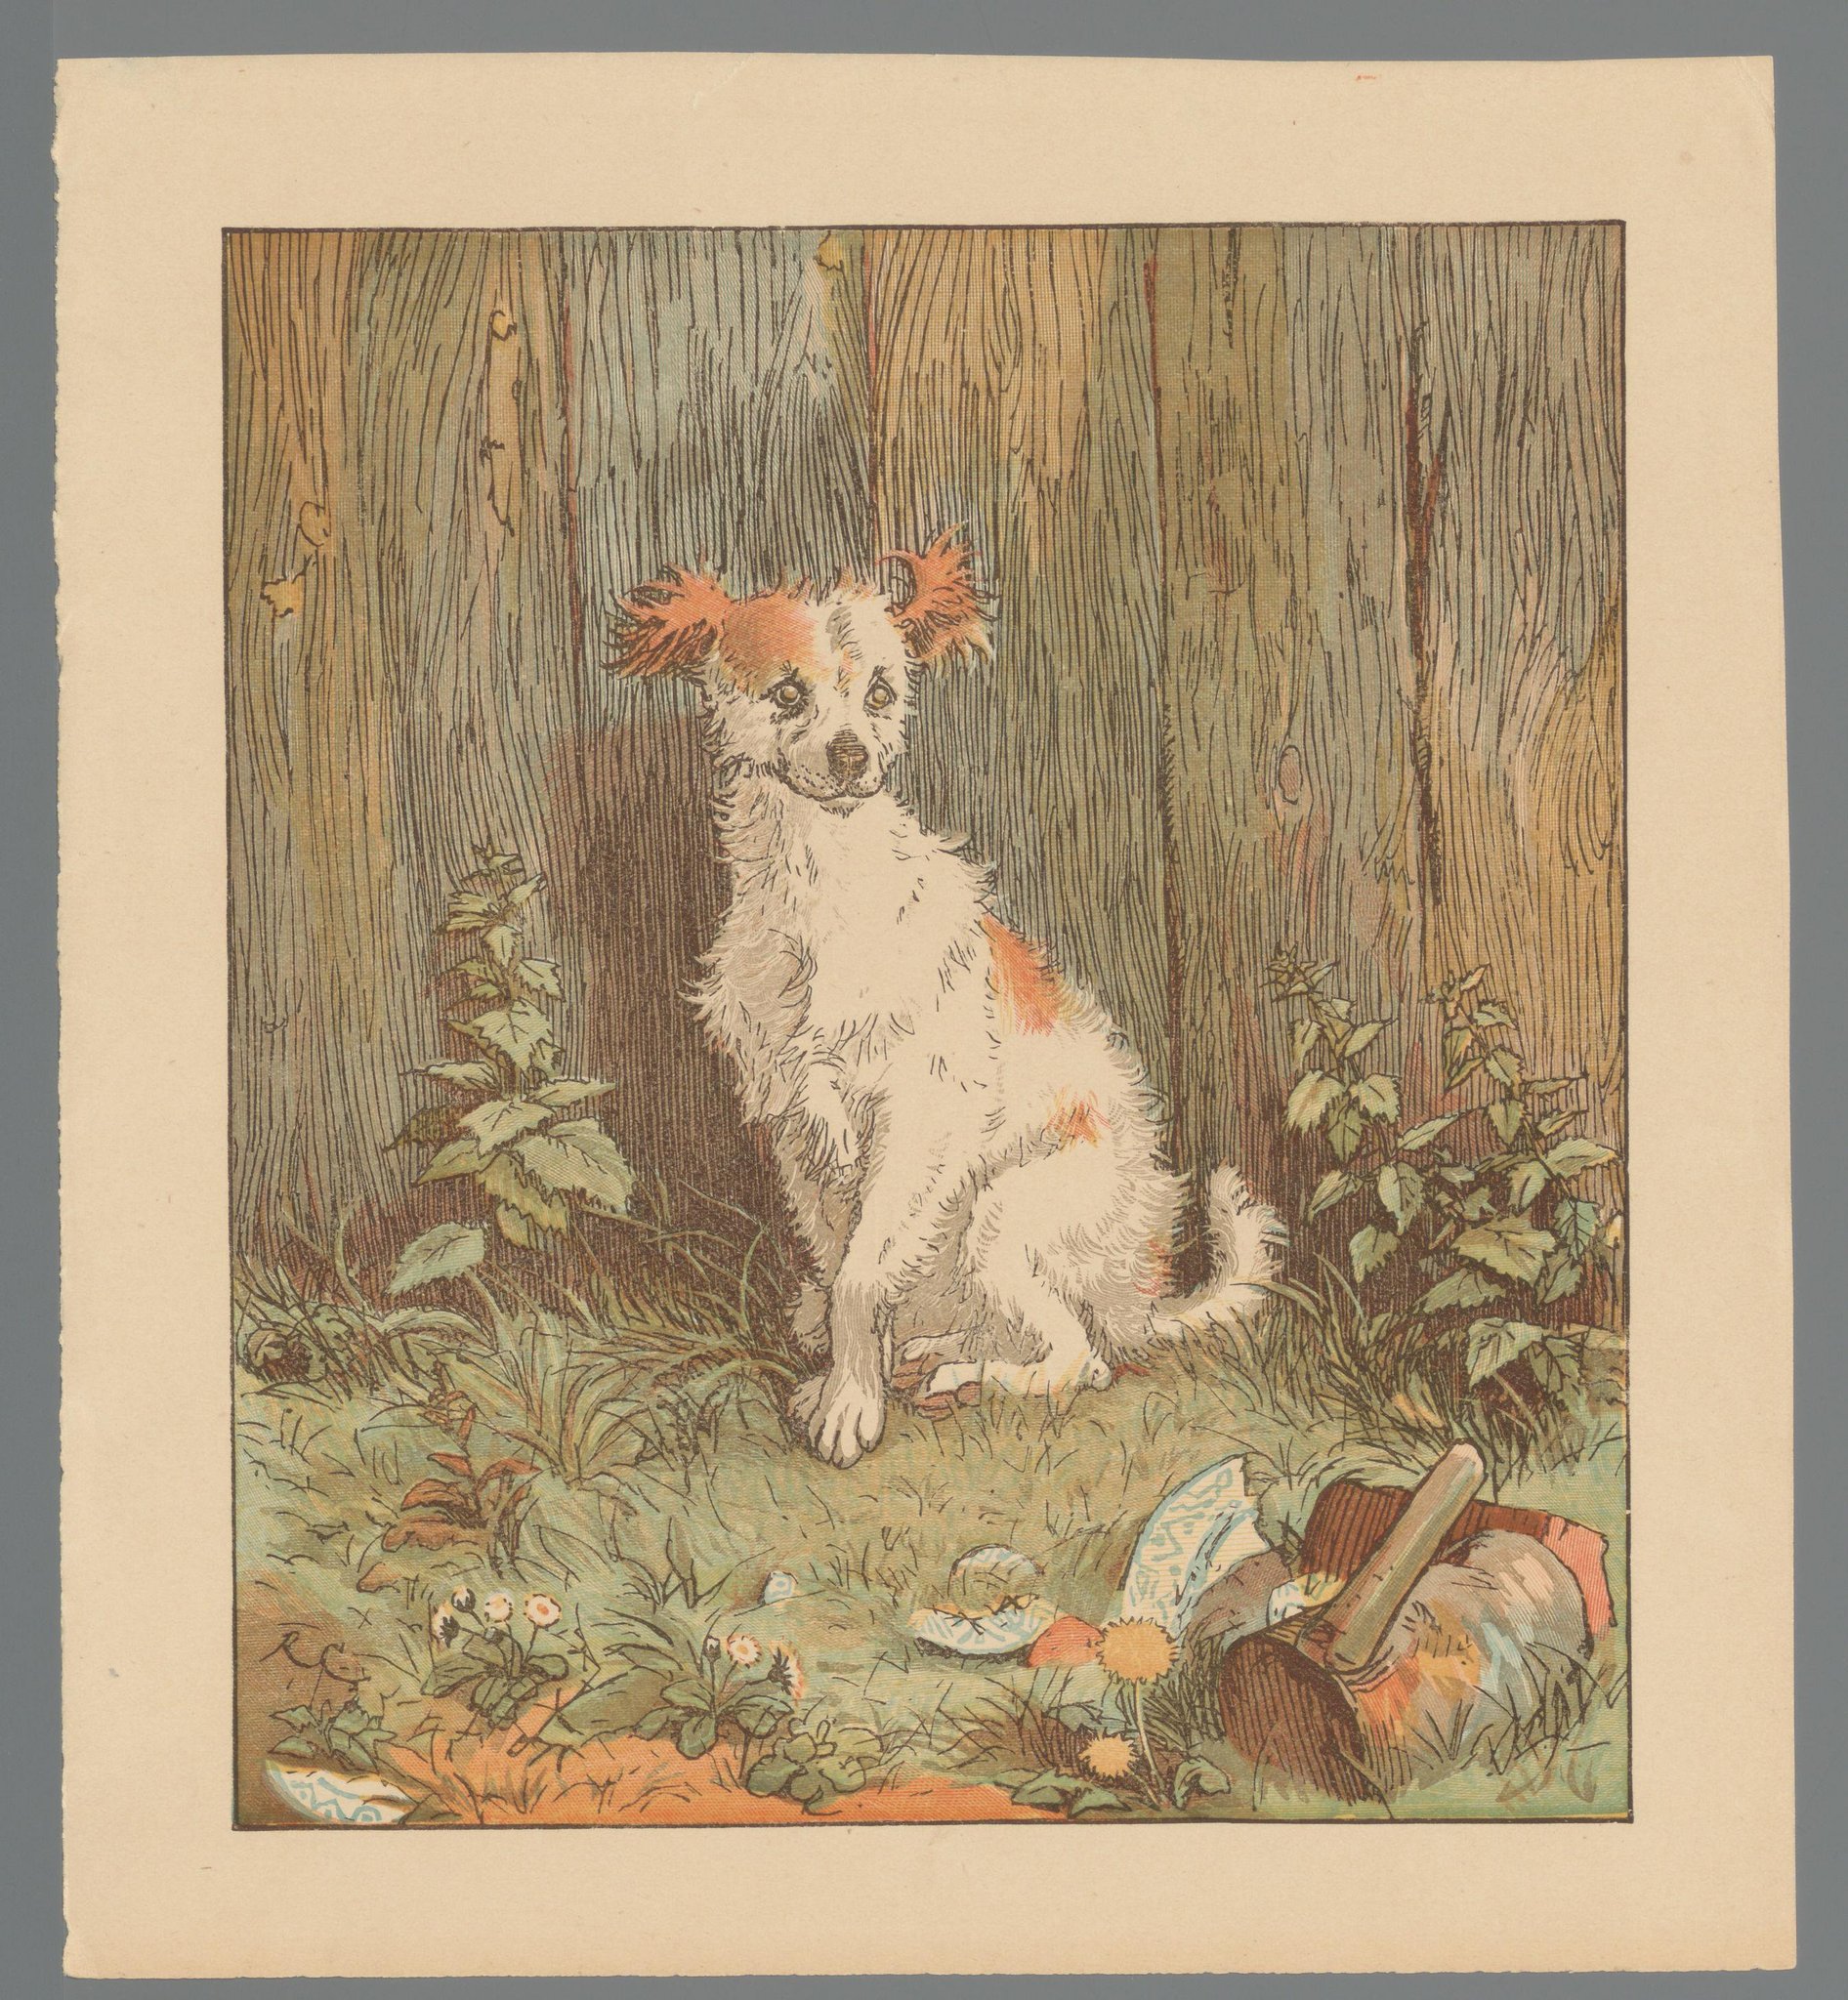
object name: print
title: Hond bij een schutting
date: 1879-1927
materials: paper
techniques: wood engraving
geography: london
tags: fence, wall, paling, dog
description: Prent uit: Goldsmith, Oliver. Elegy on a mad dog. Londen: George Routledge & Sons, 1879. Of uit een later gepubliceerde uitgave waarin vier verhalen (waaronder 'Elegy on a mad dog') zijn gebundeld.